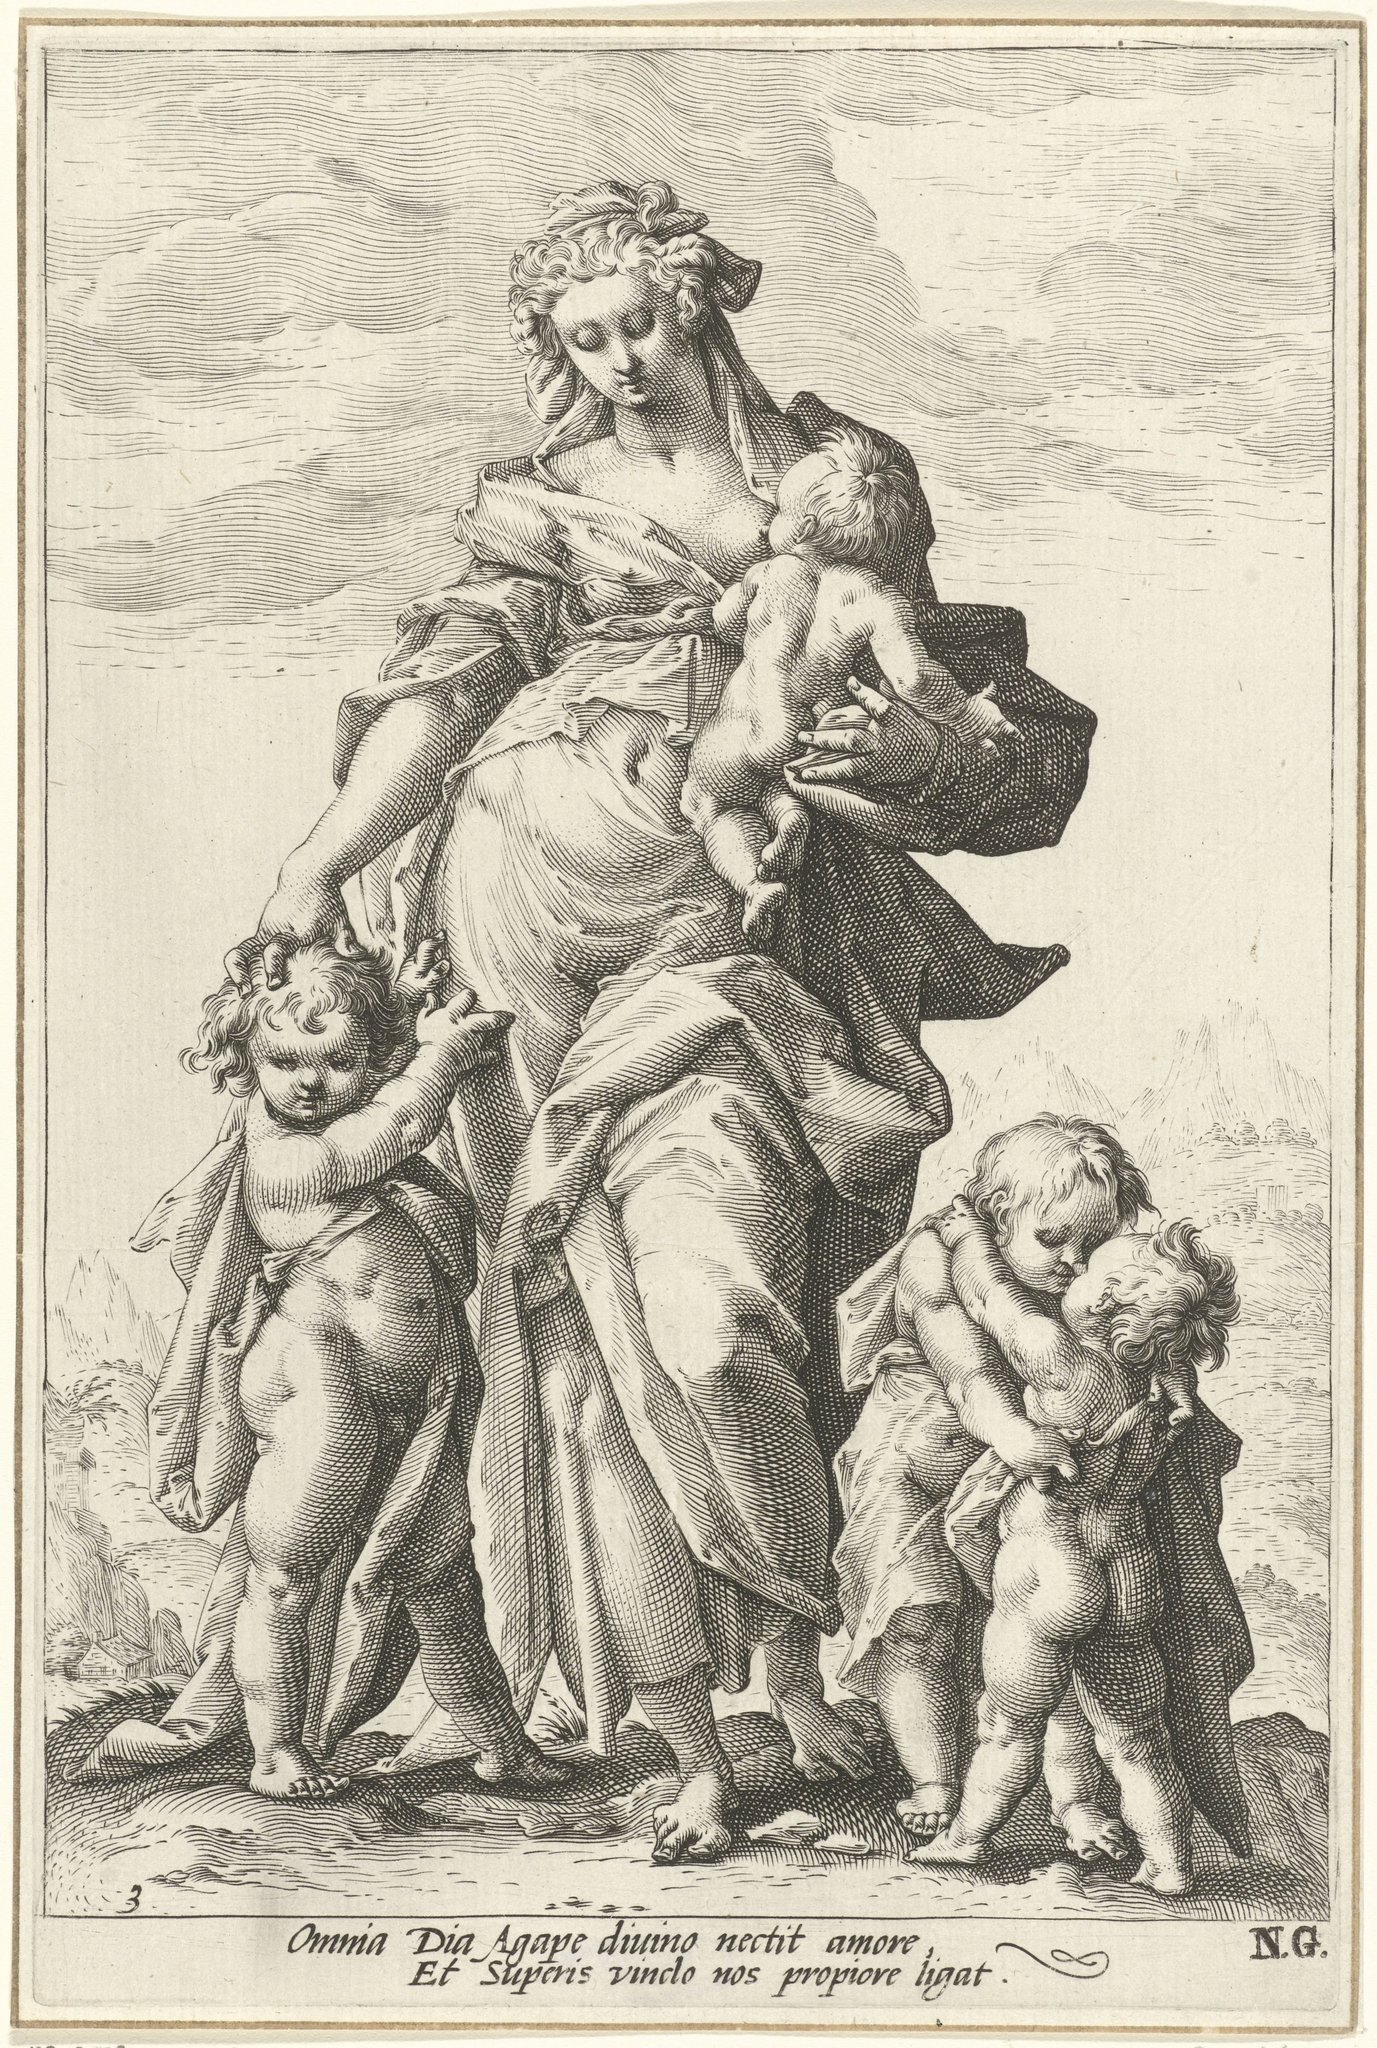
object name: print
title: De deugden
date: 1585-1589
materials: paper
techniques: engraving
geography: haarlem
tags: charity, 'caritas'; 'carità' (ripa) ~ one of the three theological virtues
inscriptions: collector's mark: Lugt 2228, collector's mark: Lugt 1967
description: De gepersonifieerde Liefde; een vrouwenfiguur omringd met kinderen.